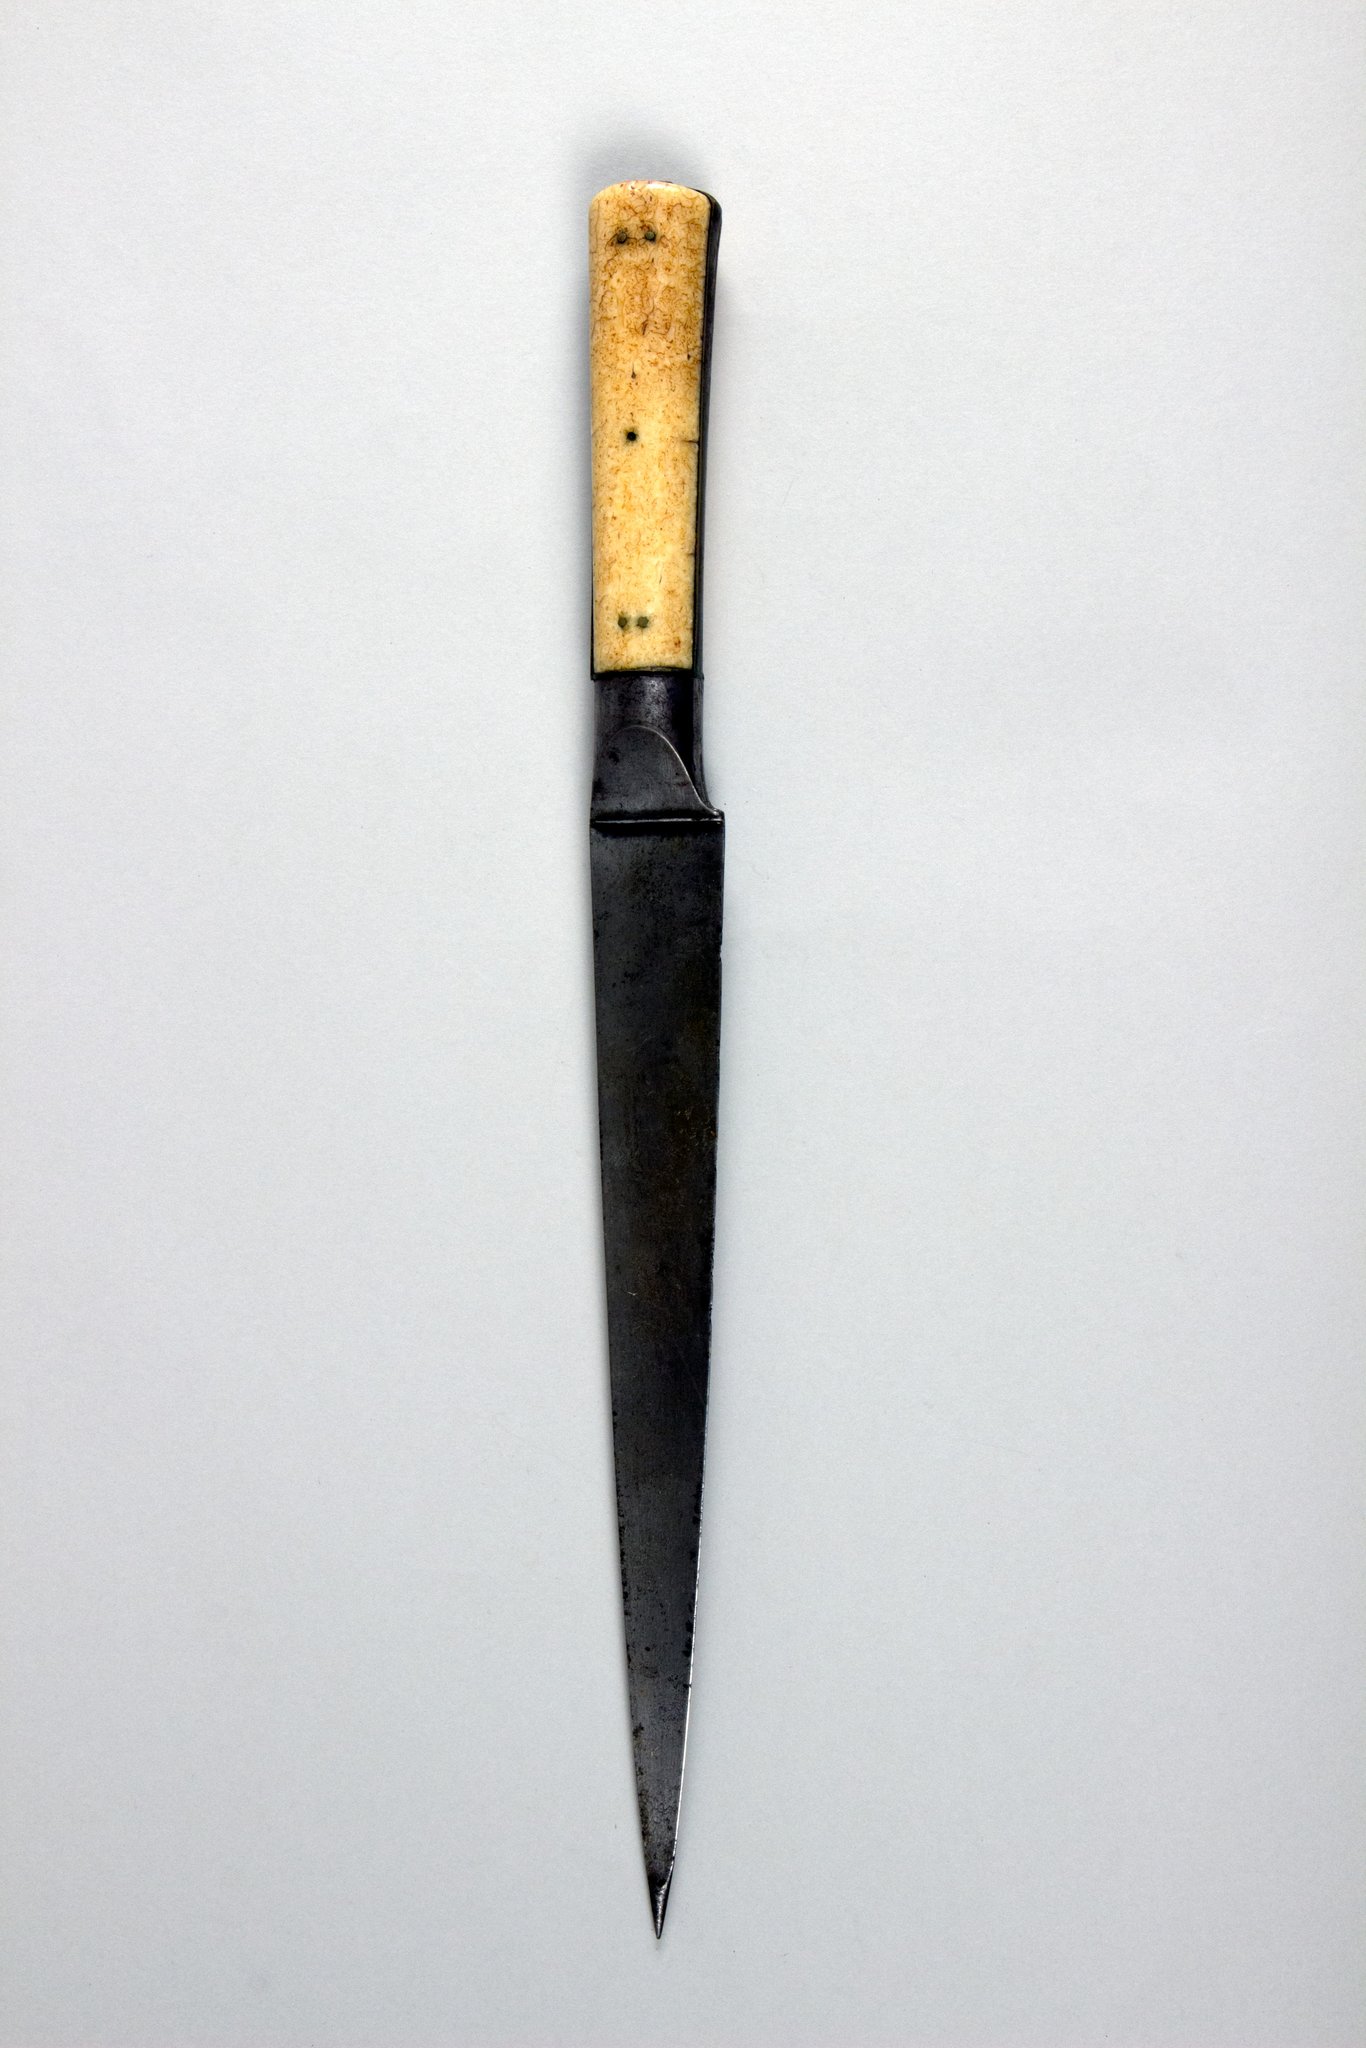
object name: dagger kard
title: Dagger (Kard)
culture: persian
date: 1701-1900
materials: steel, pigment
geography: iran